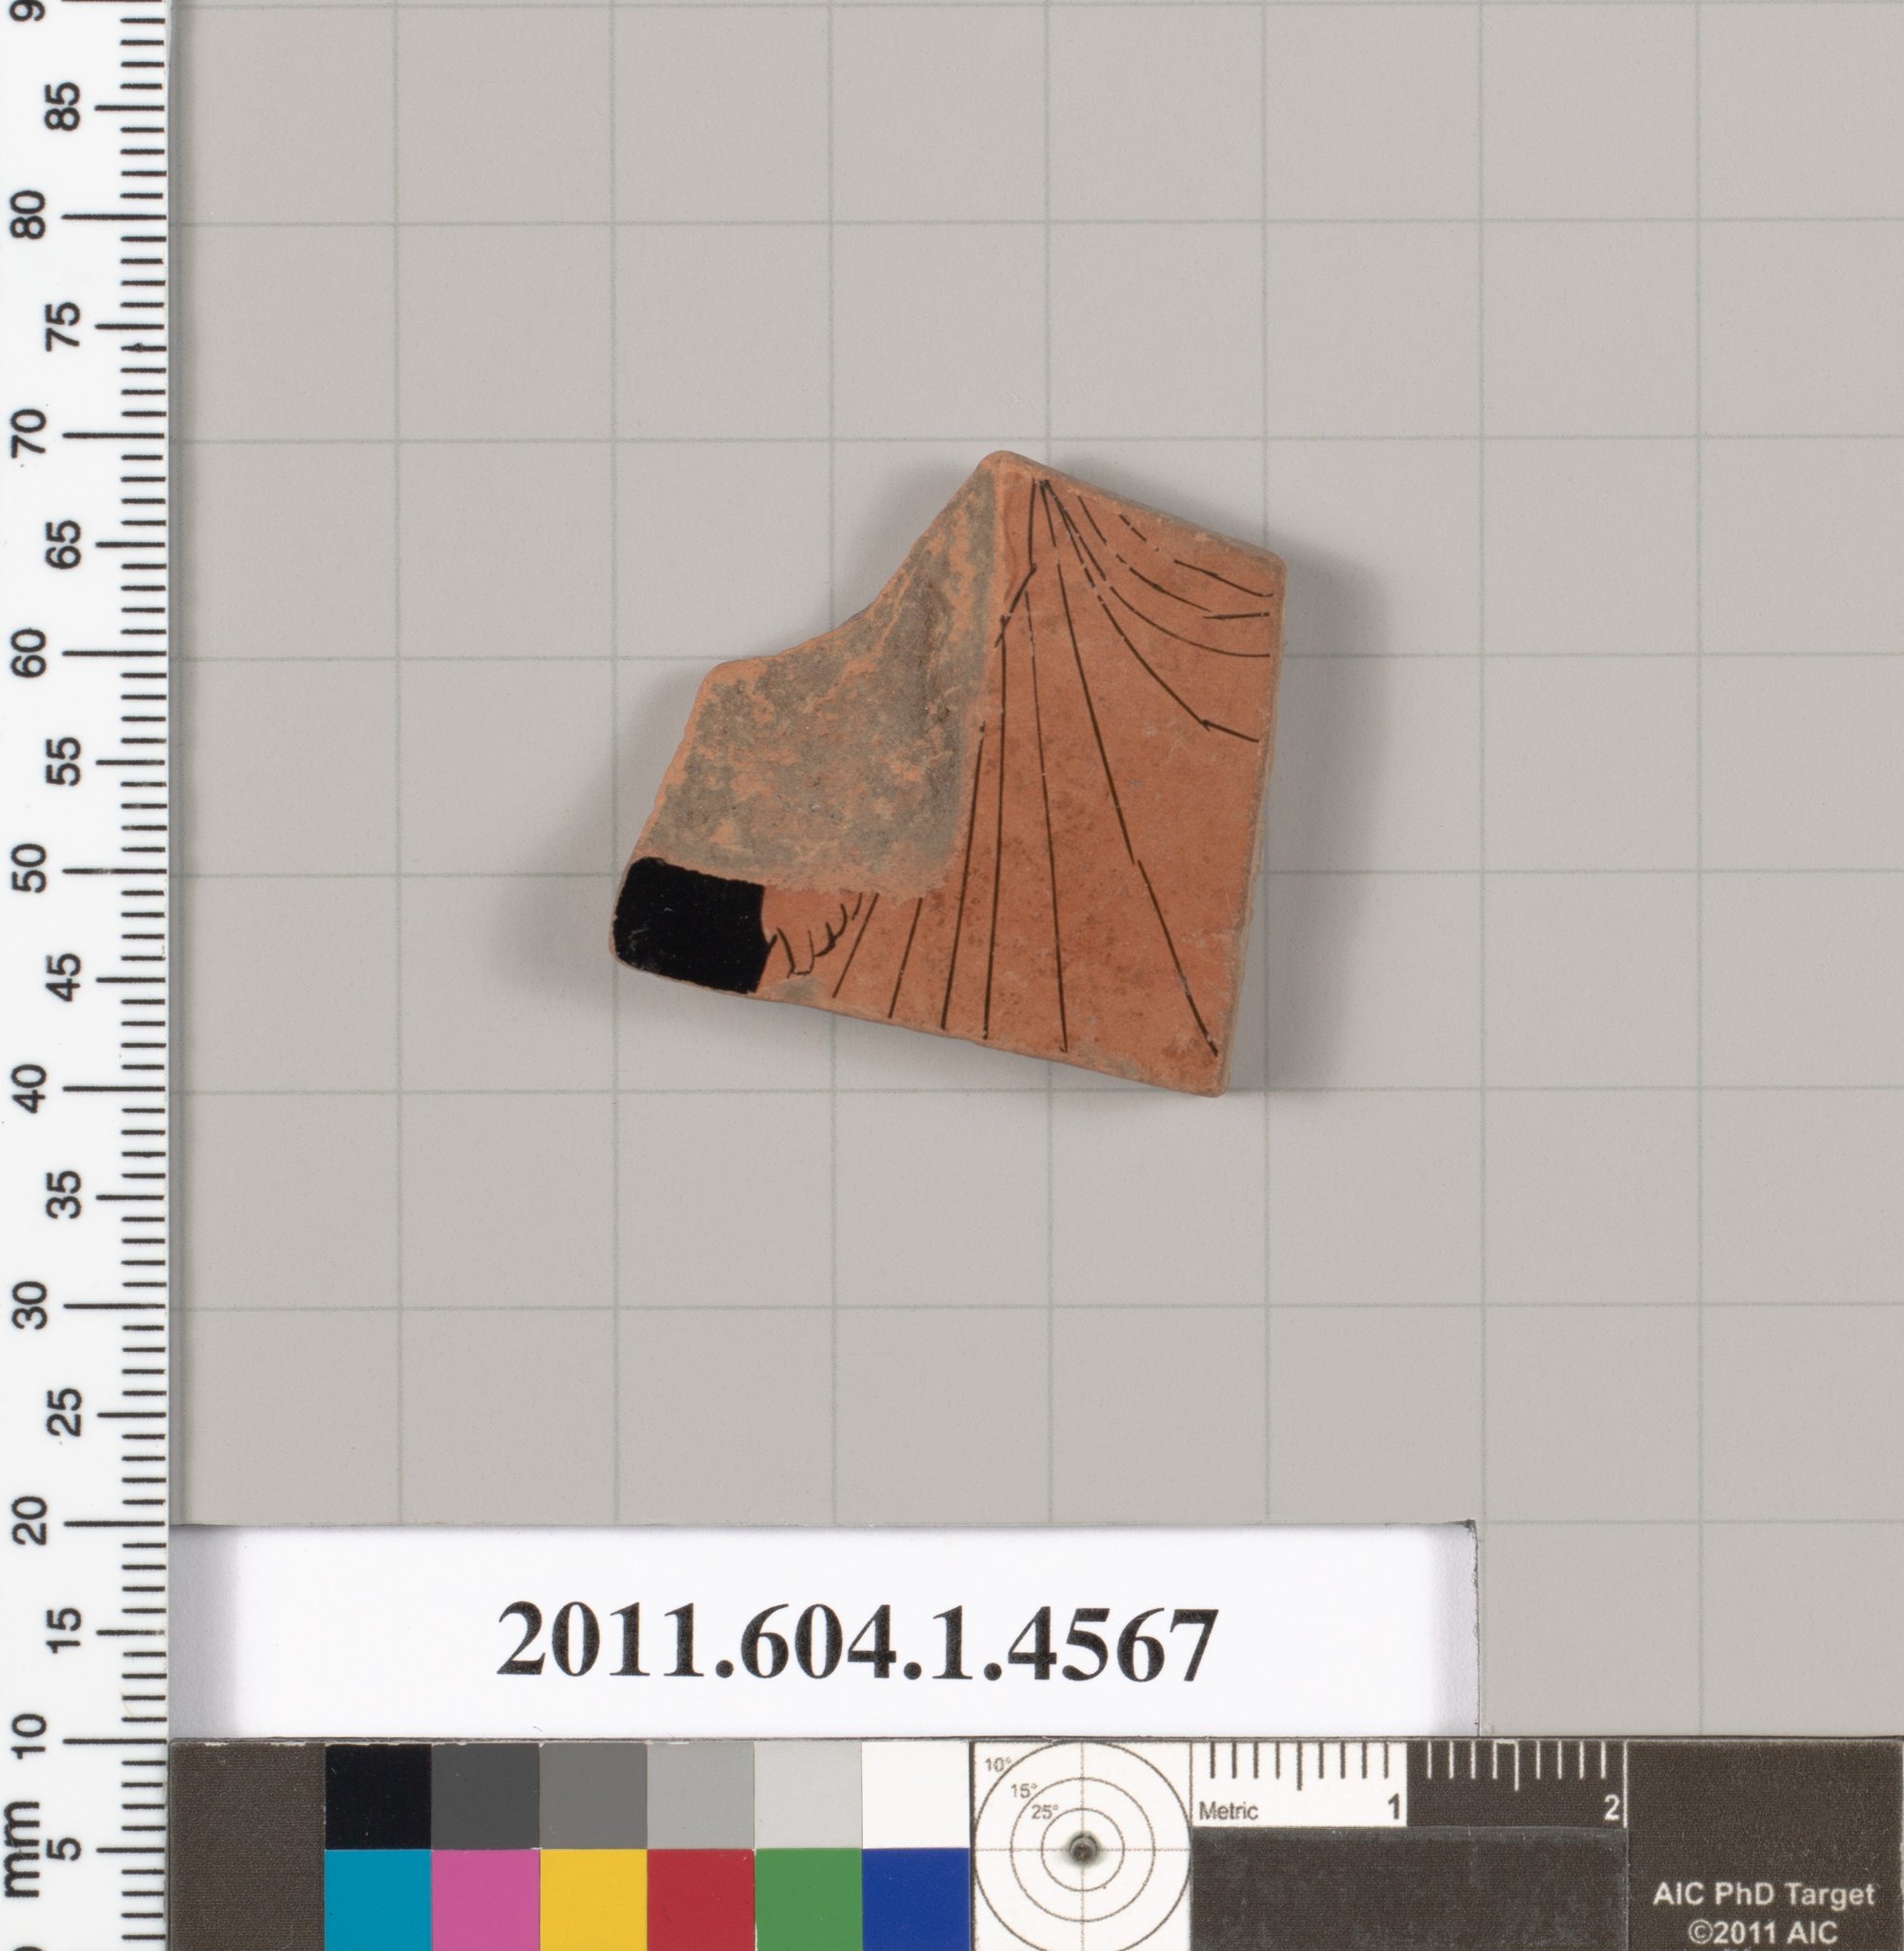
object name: kylix fragment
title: Terracotta fragment of a kylix (drinking cup)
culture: greek, attic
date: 490-470 BCE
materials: terracotta